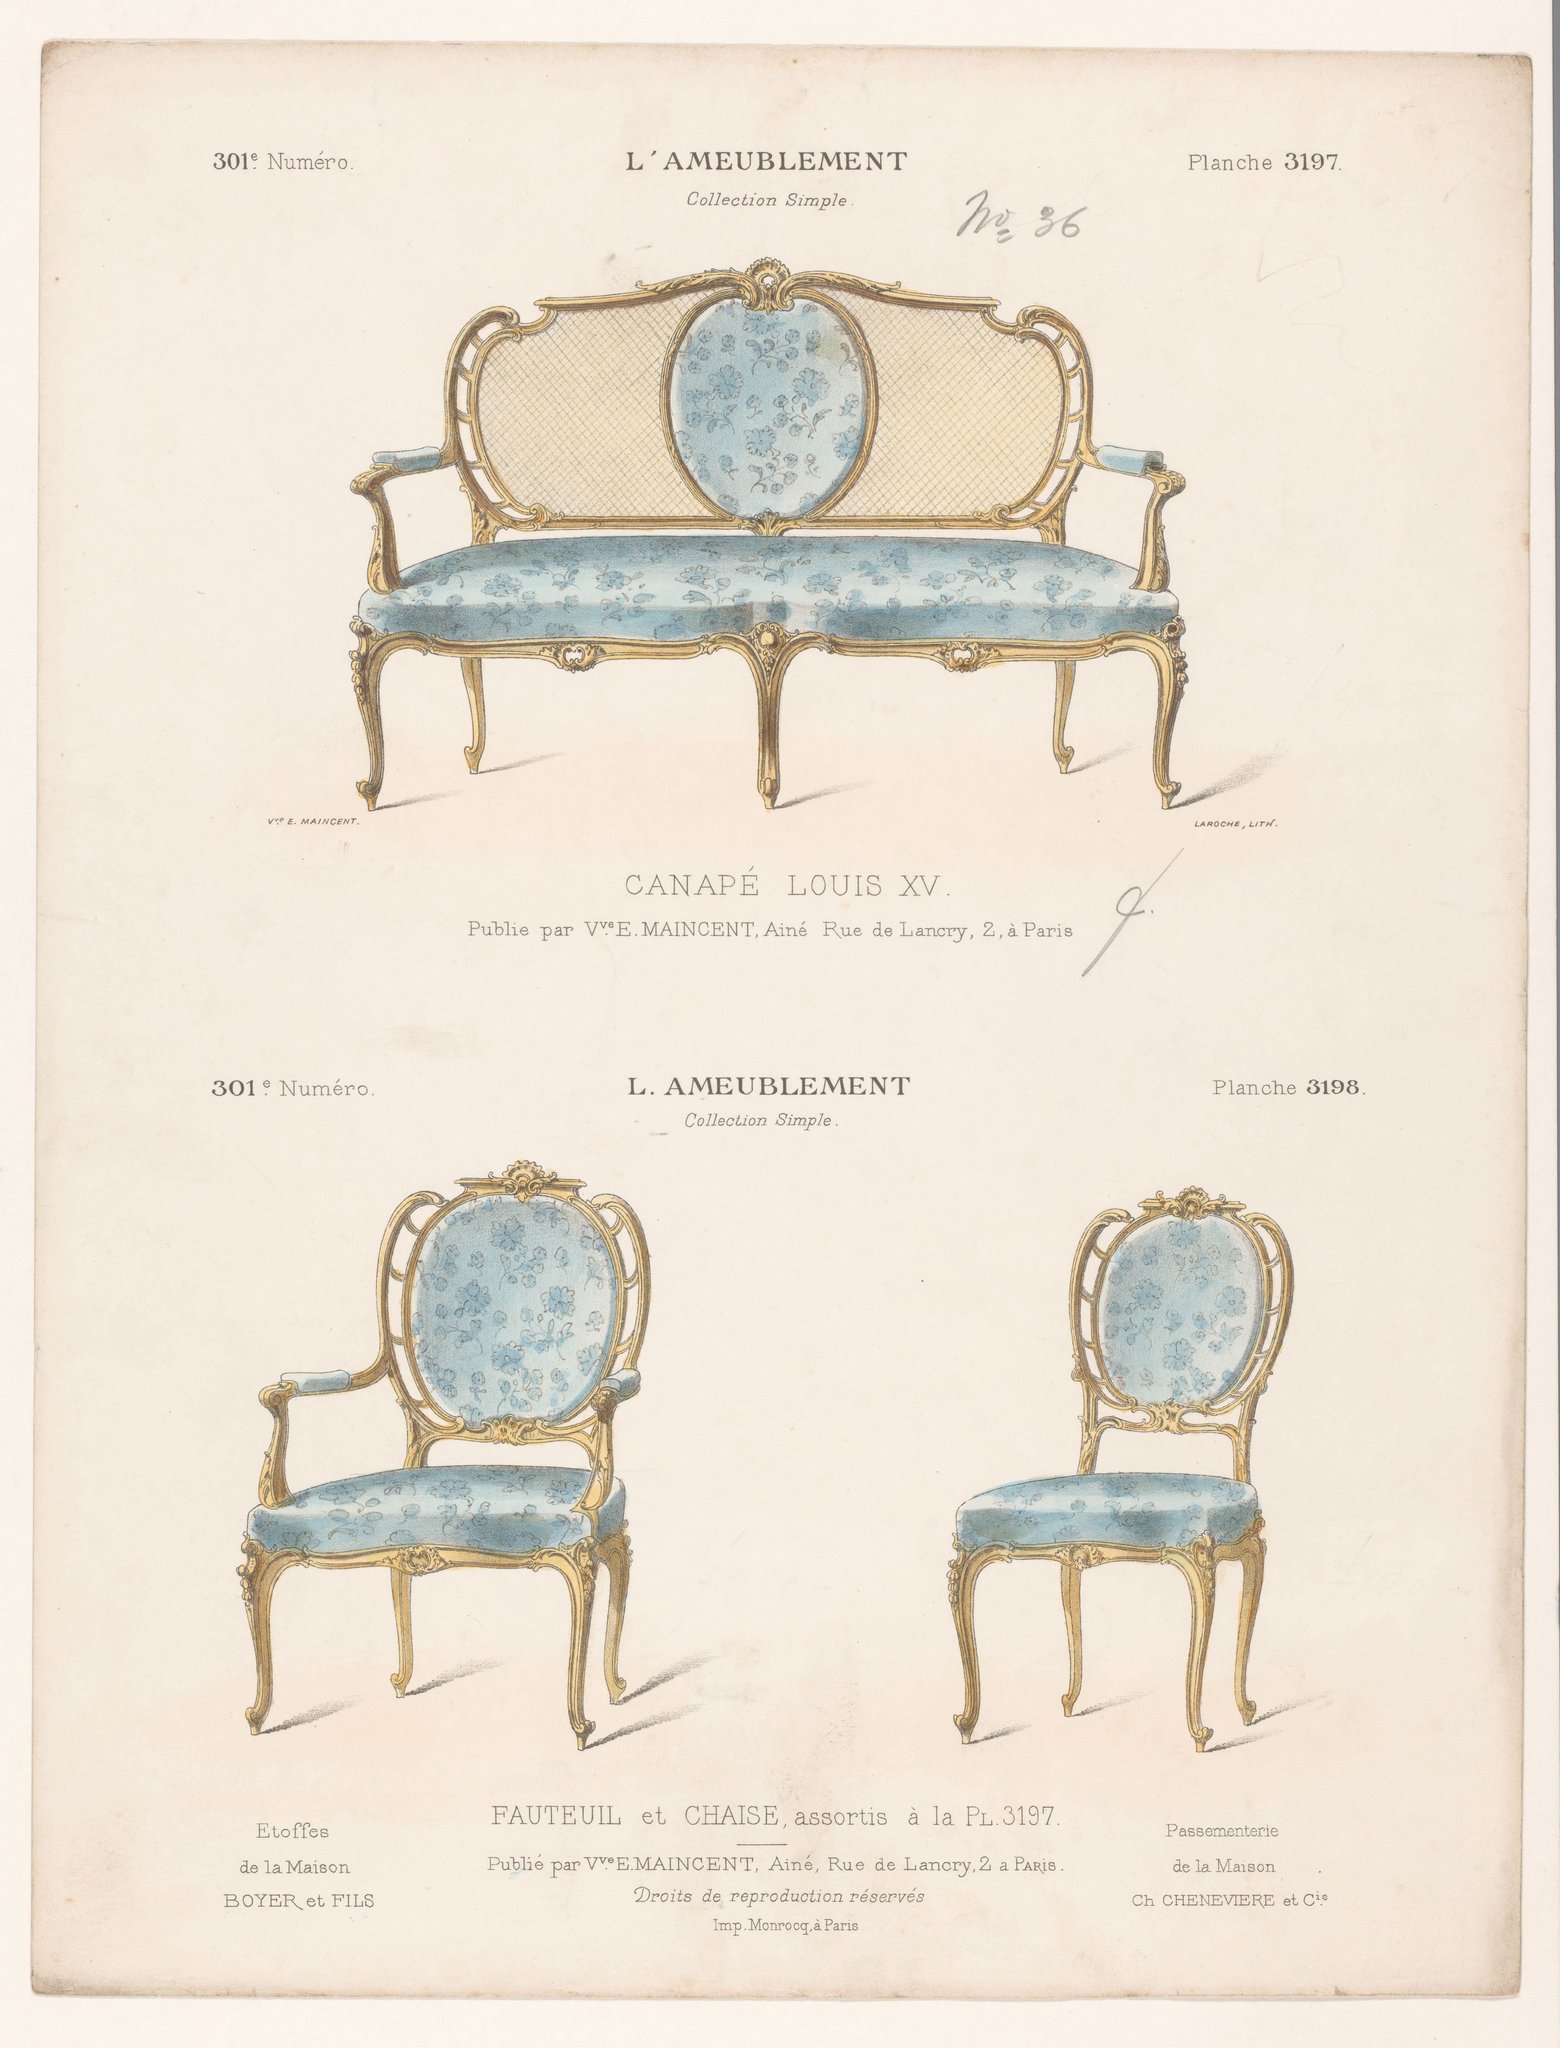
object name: print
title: Canapé Louis XV / Fauteuil et chaise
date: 1895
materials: paper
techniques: hand coloring, lithograph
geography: paris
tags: seating furniture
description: Een canapé, fauteuil en een stoel in de Lodewijk XV-stijl. Prent uit 301e nummer (livraison).